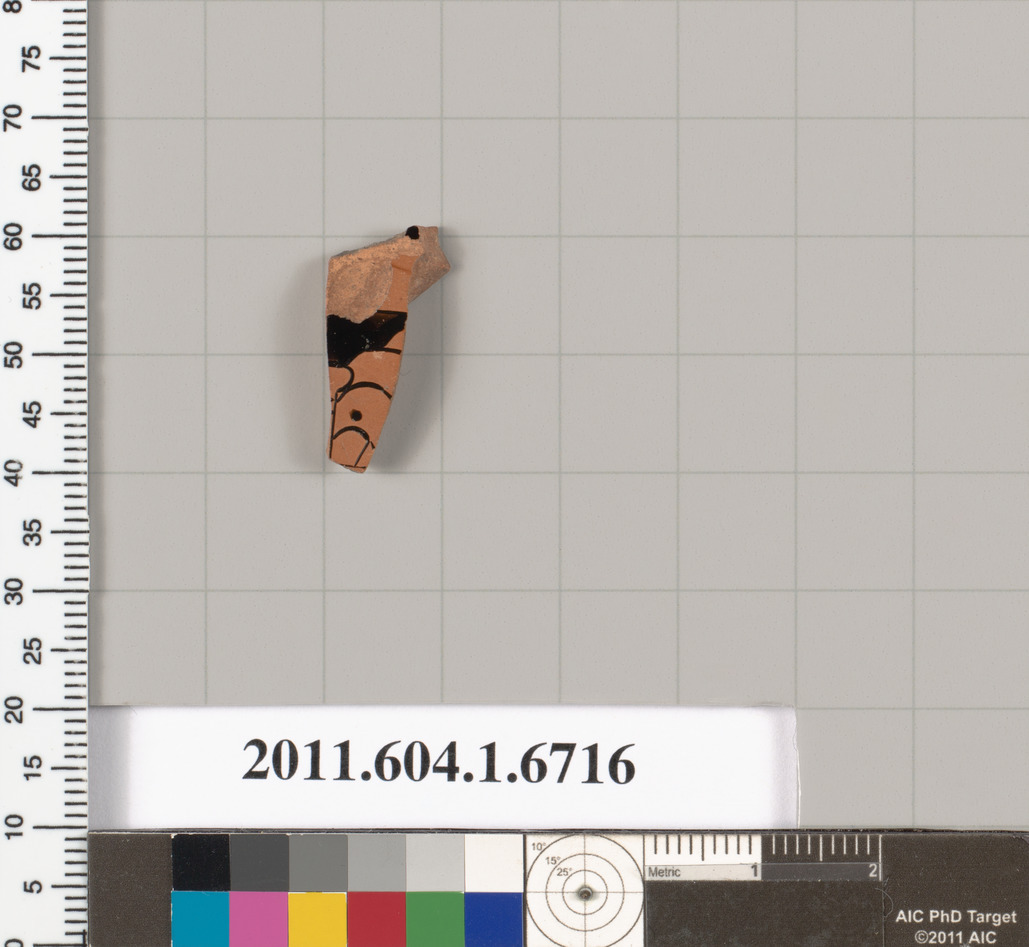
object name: kylix fragment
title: Terracotta fragment of a kylix (drinking cup)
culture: greek, attic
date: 490-470 BCE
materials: terracotta